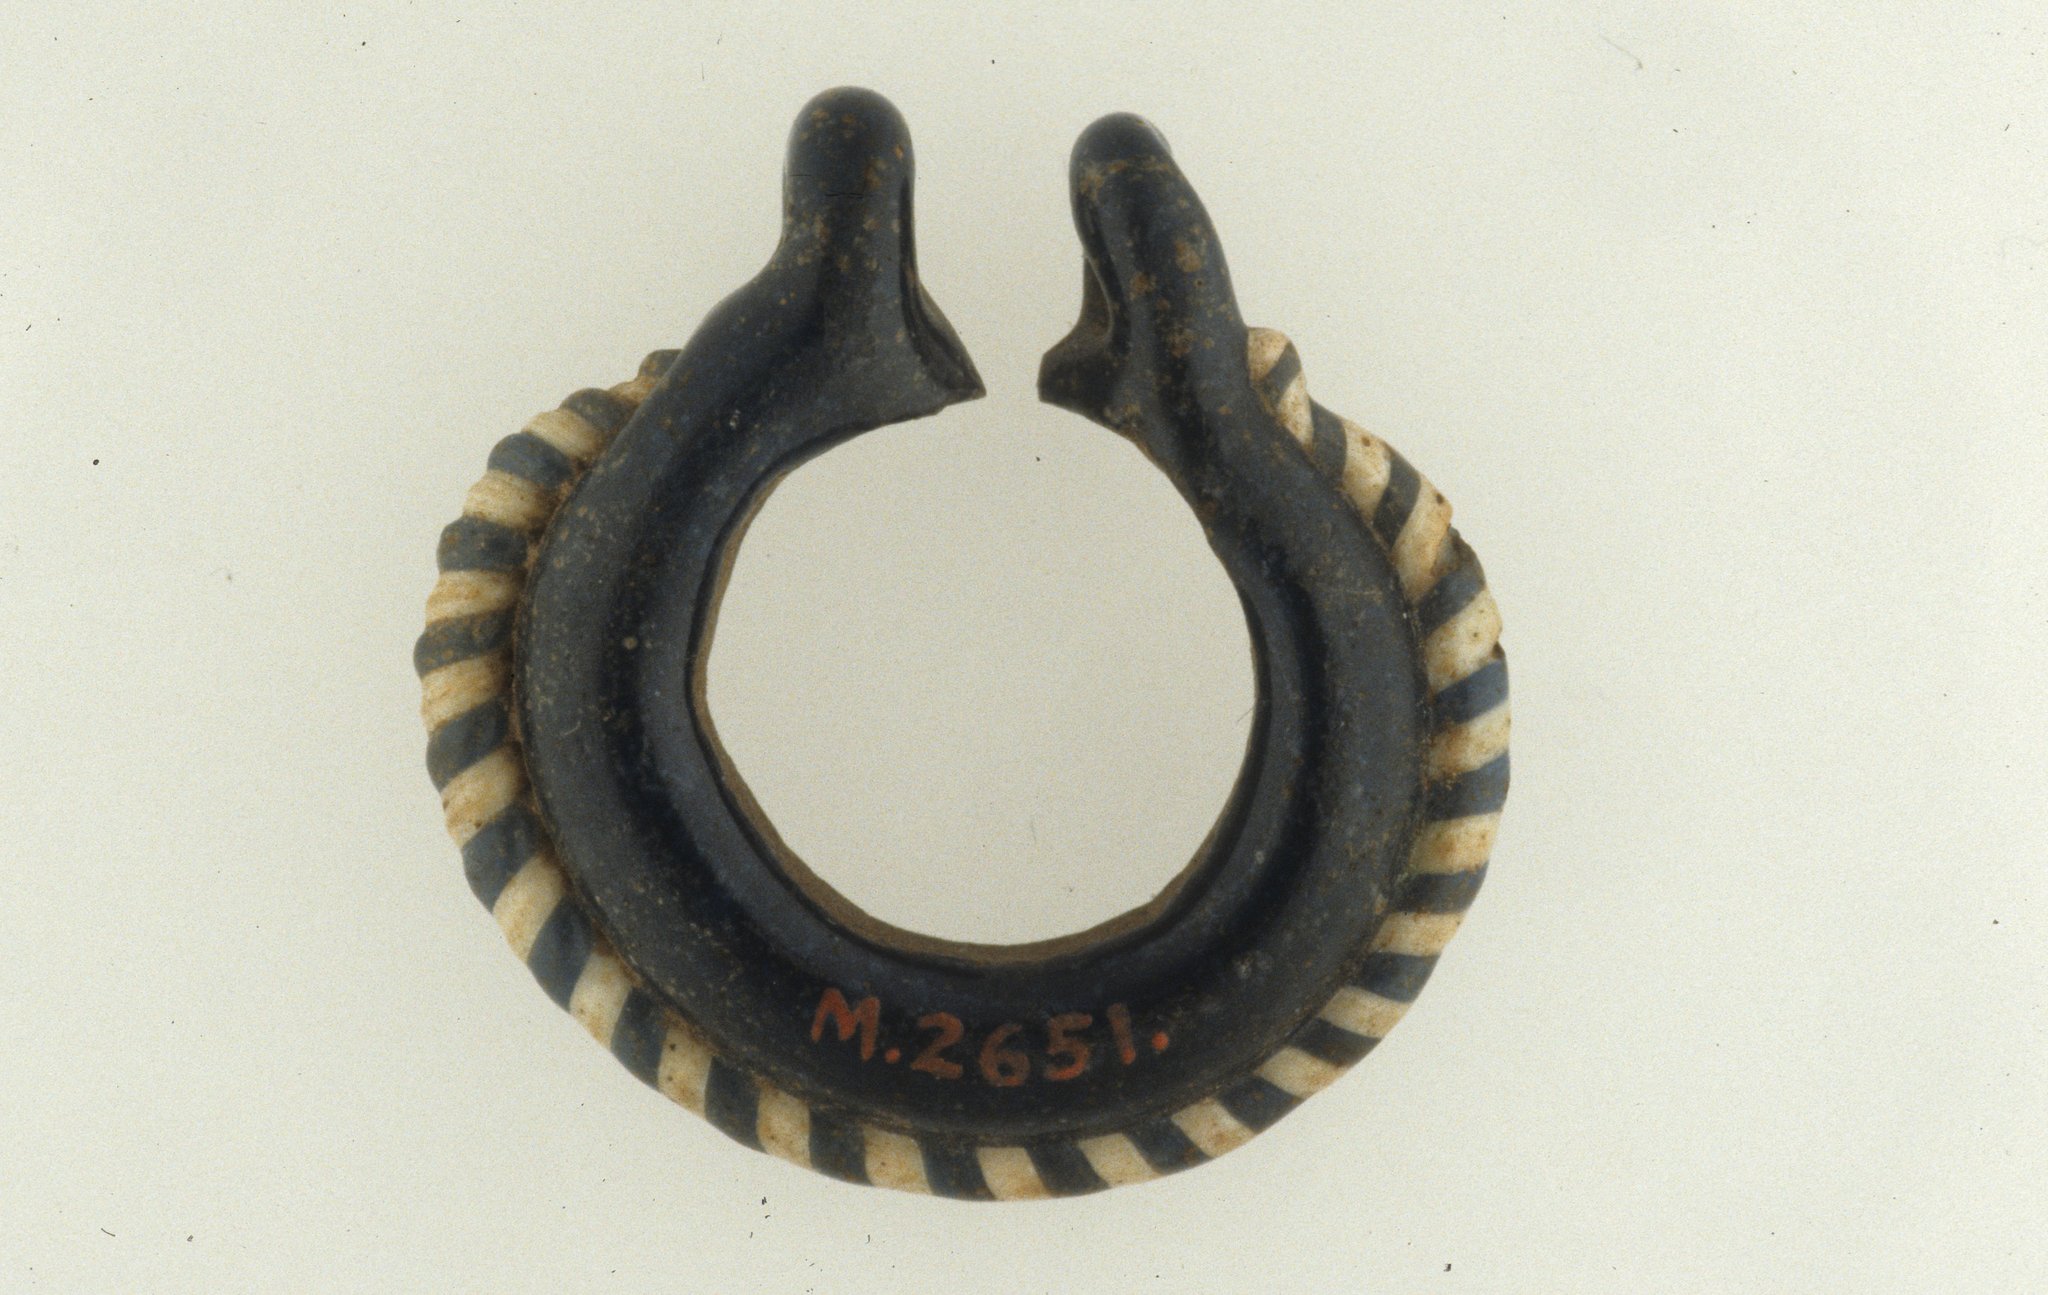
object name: earring, penannular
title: Earring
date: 1400-1295 BCE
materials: glass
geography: egypt